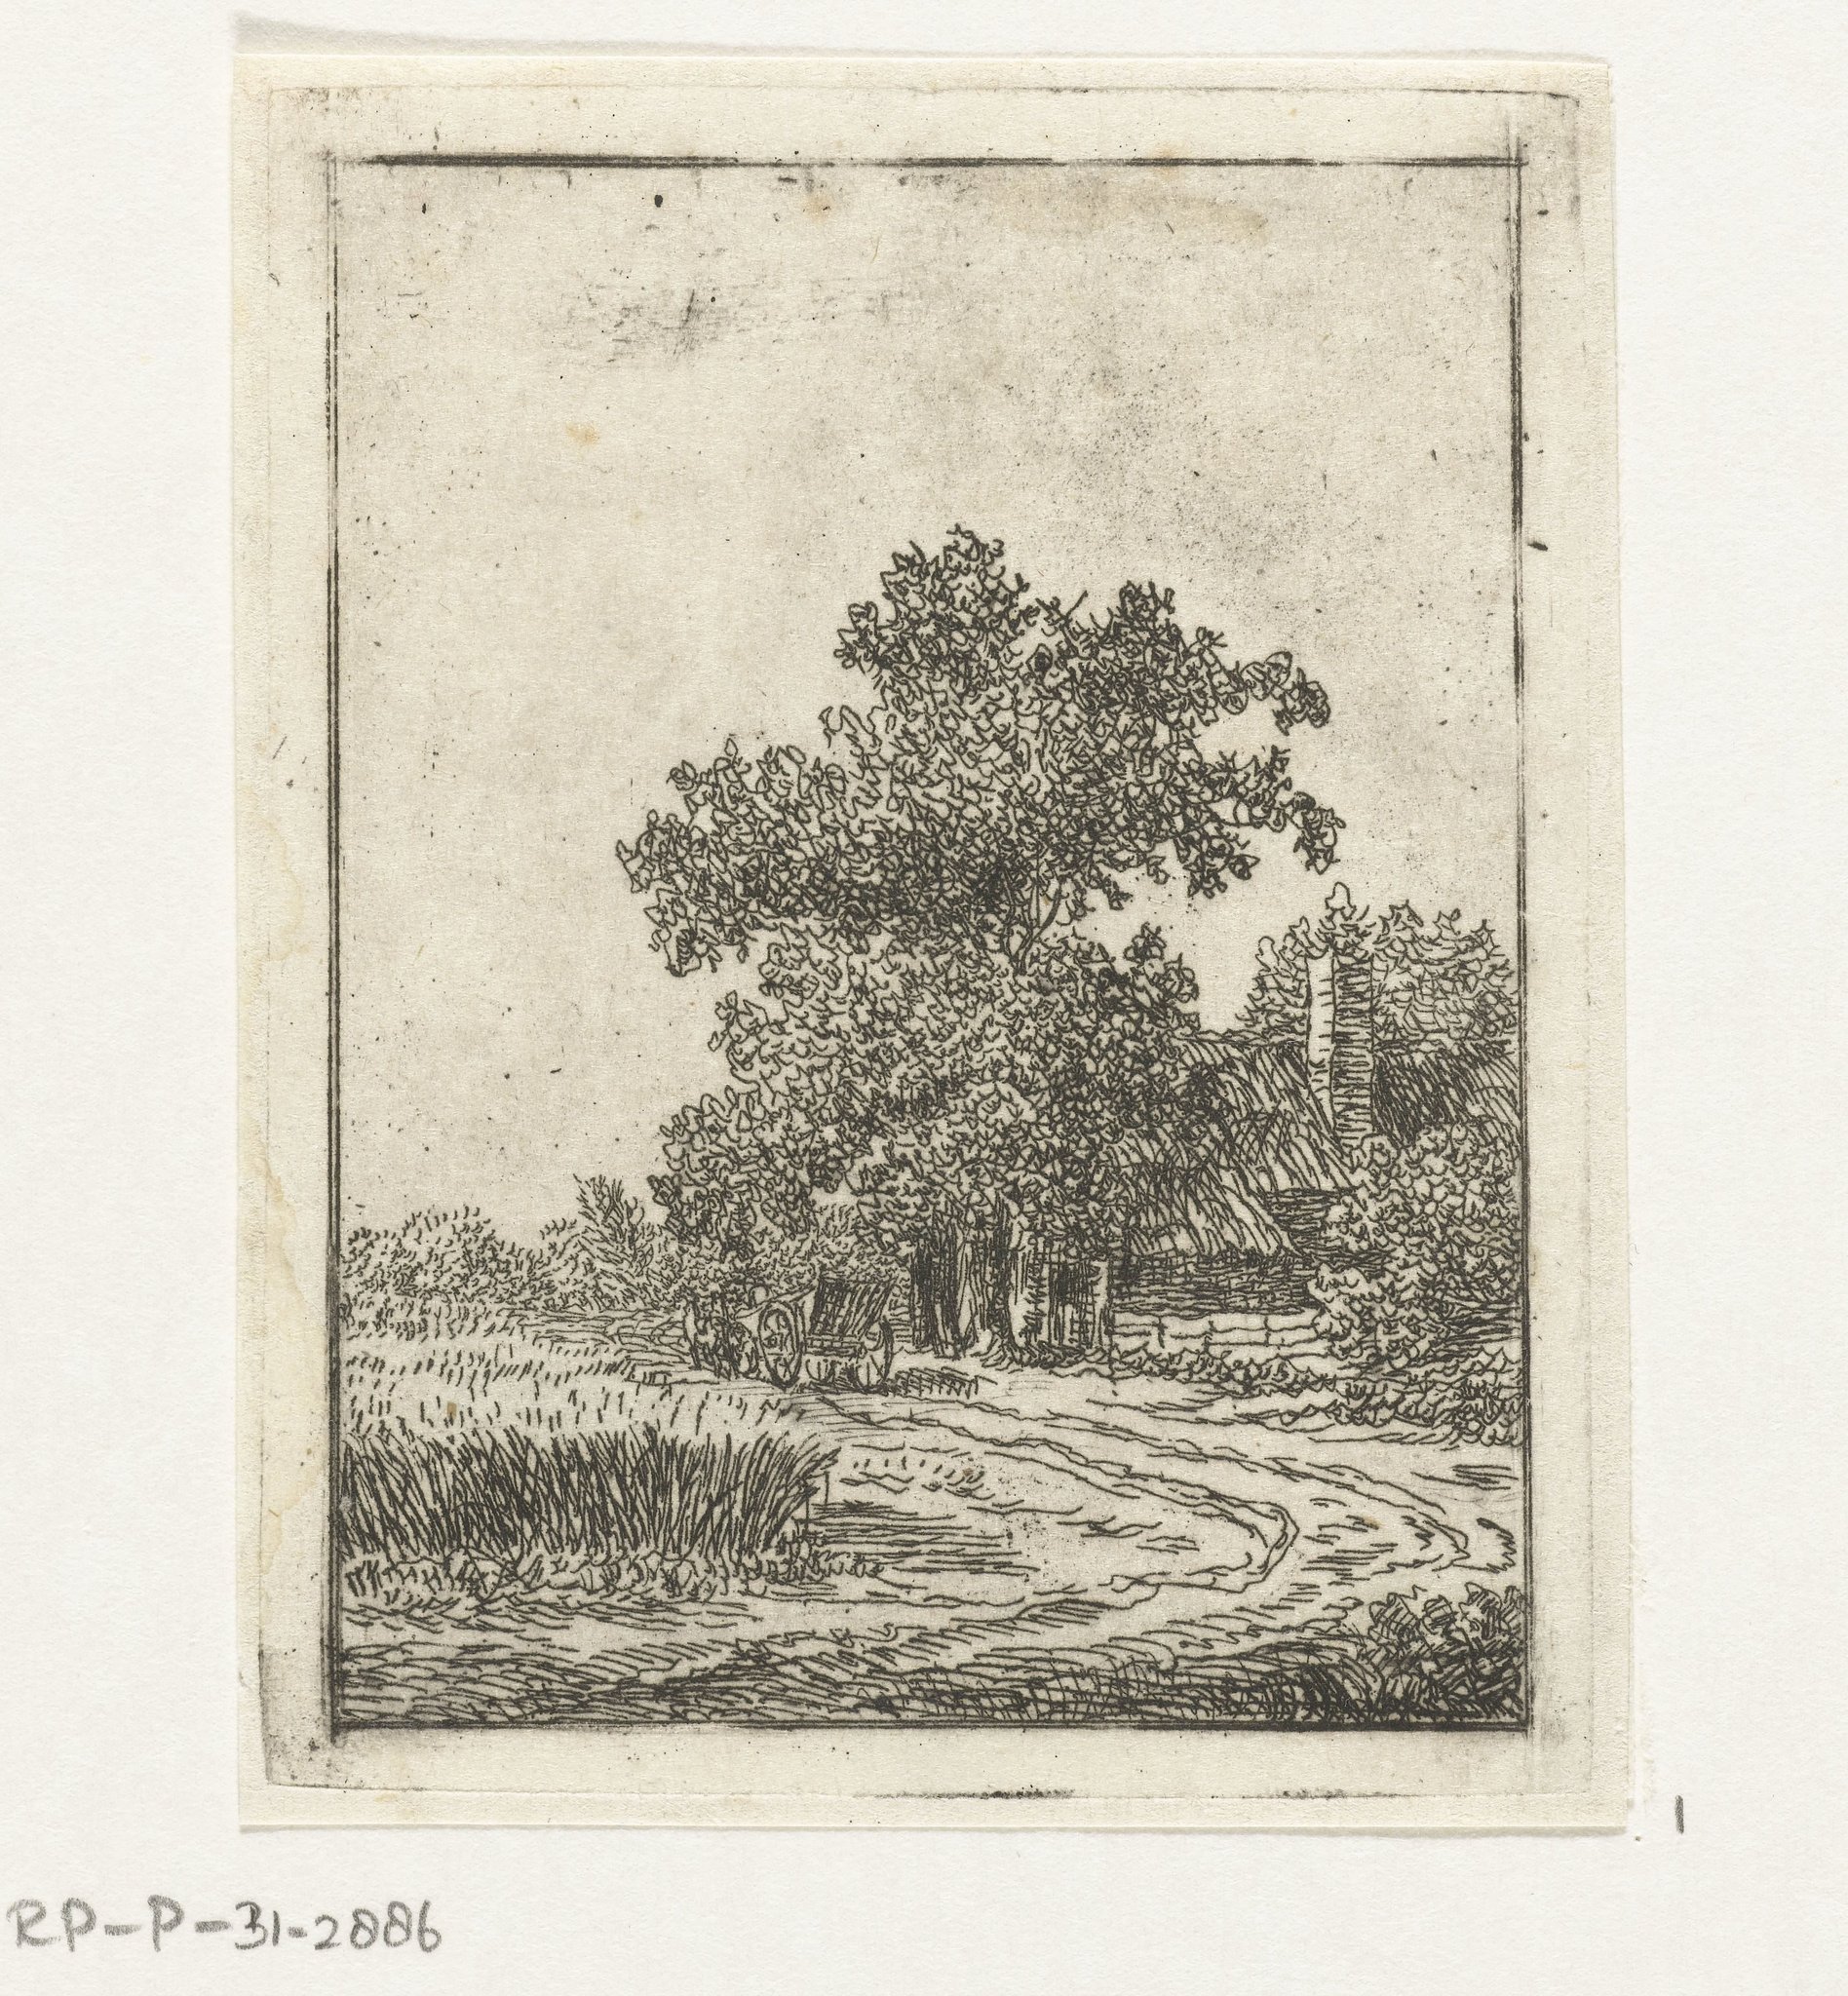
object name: print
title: Boerenkar staande voor een boerderij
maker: anthonie van den bos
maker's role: draughtsman, print maker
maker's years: 1763-1838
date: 1778-1838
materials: paper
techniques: etching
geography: netherlands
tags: farm or solitary house in landscape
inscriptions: collector's mark: Lugt 2228